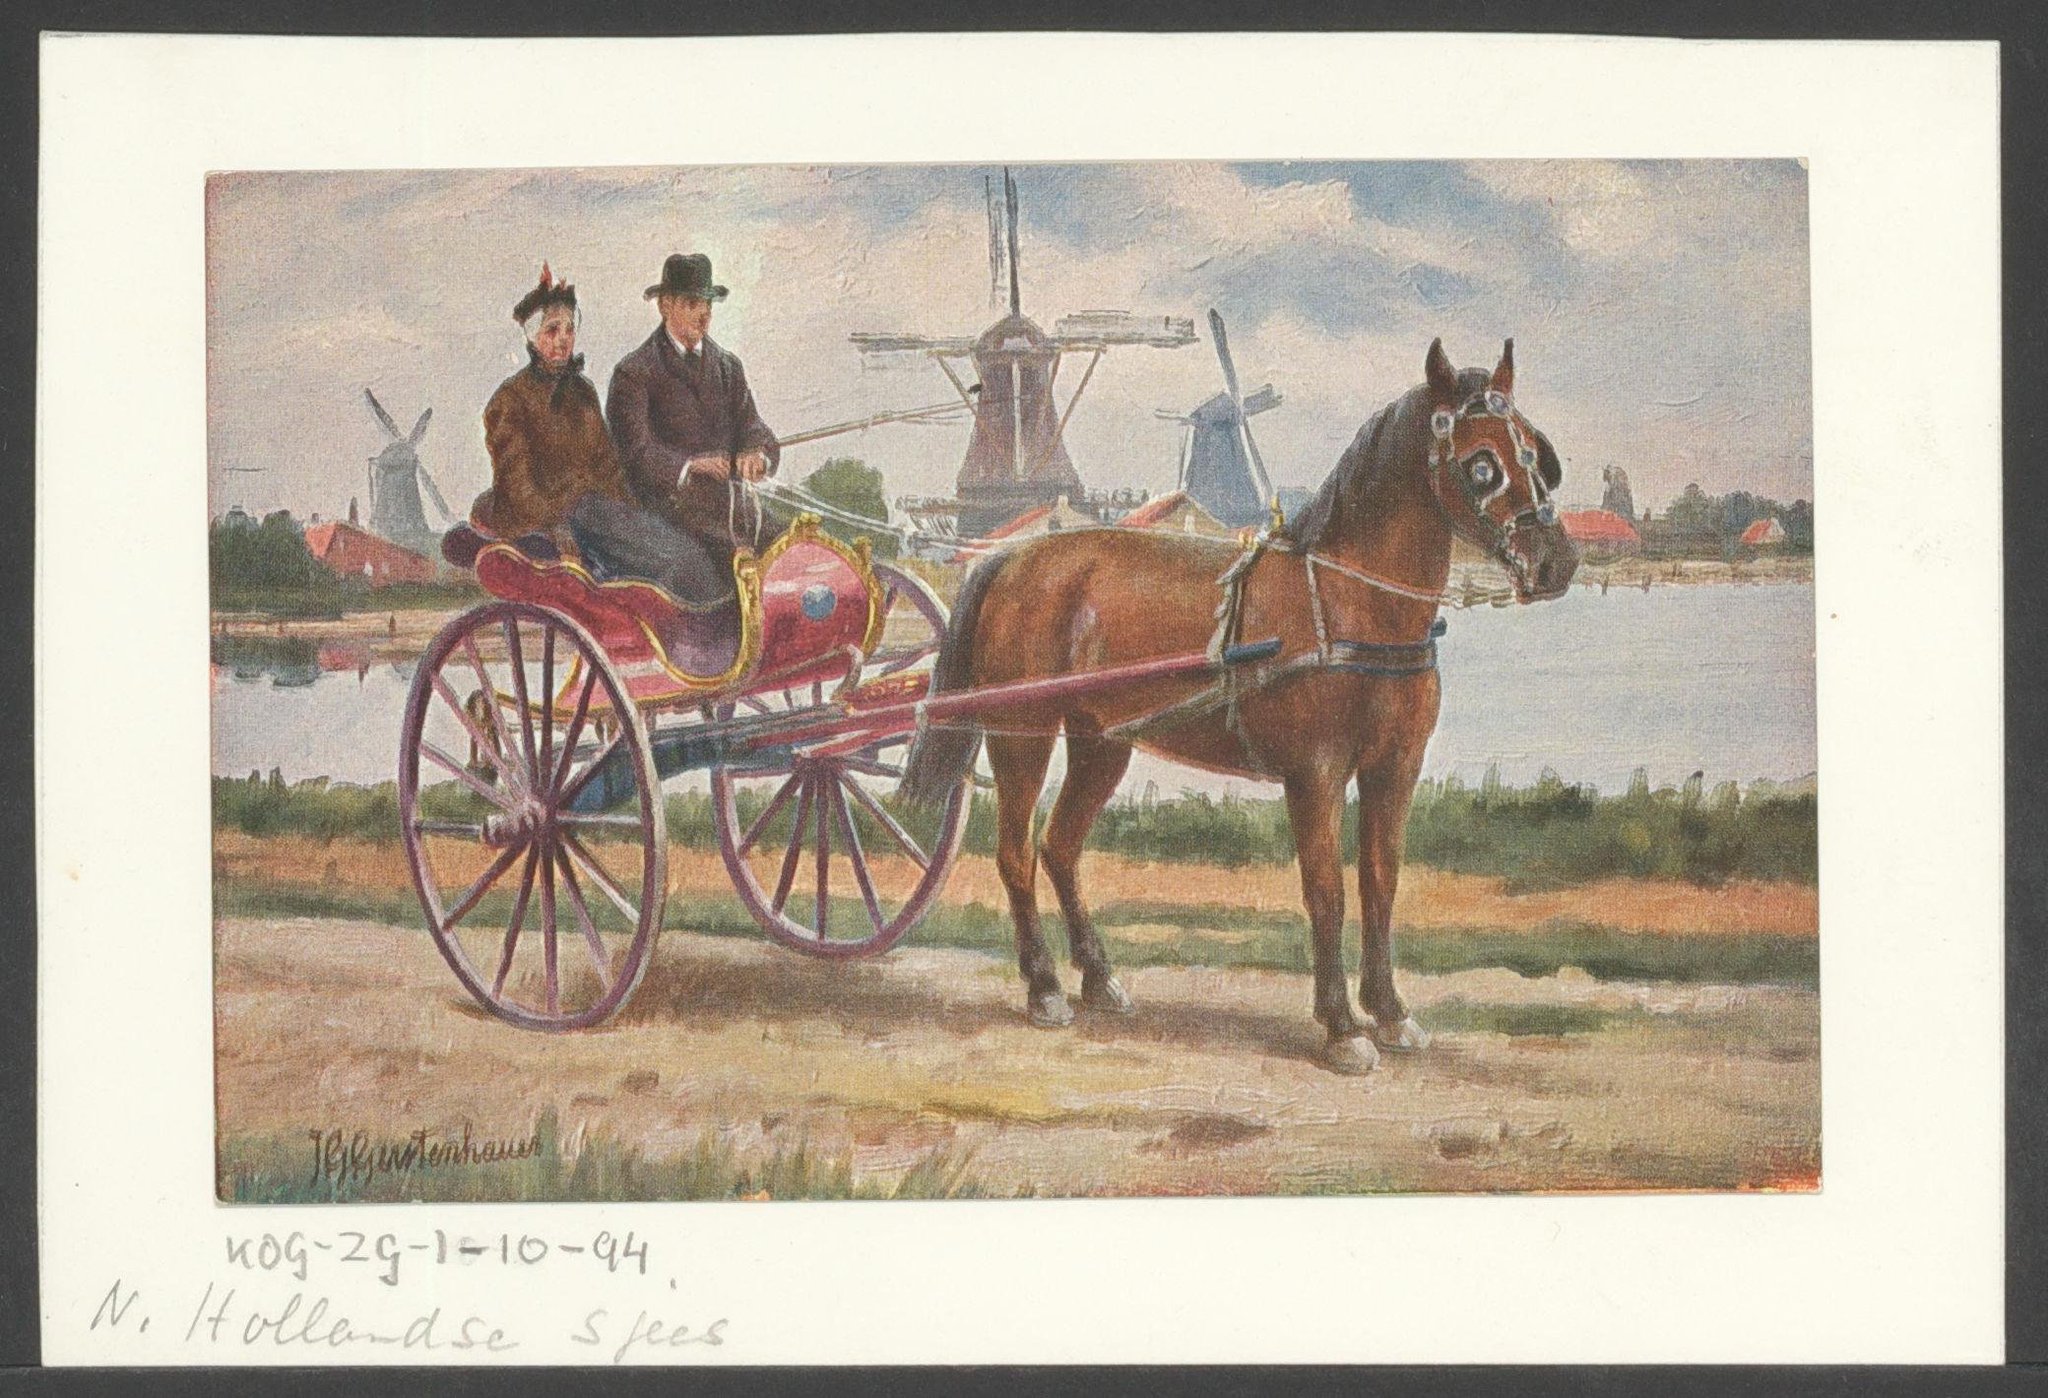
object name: photomechanical print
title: Stel in een Noord-Hollandse sjees getrokken door een paard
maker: Anonymous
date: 1900-1920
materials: paper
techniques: letterpress printing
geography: amsterdam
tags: two-wheeled, animal-drawn vehicle, windmill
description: Stel in een Noord-Hollandse sjees getrokken door een paard. Op de achtergrond drie molen. Onderwerpsrubrieken binnen de Atlas Zeden en Gewoonten: Handel, nijverheid en verkeer, Vervoermiddelen te land en te water, vervoermiddelen te land, Sjeezen en Boerenwagens.